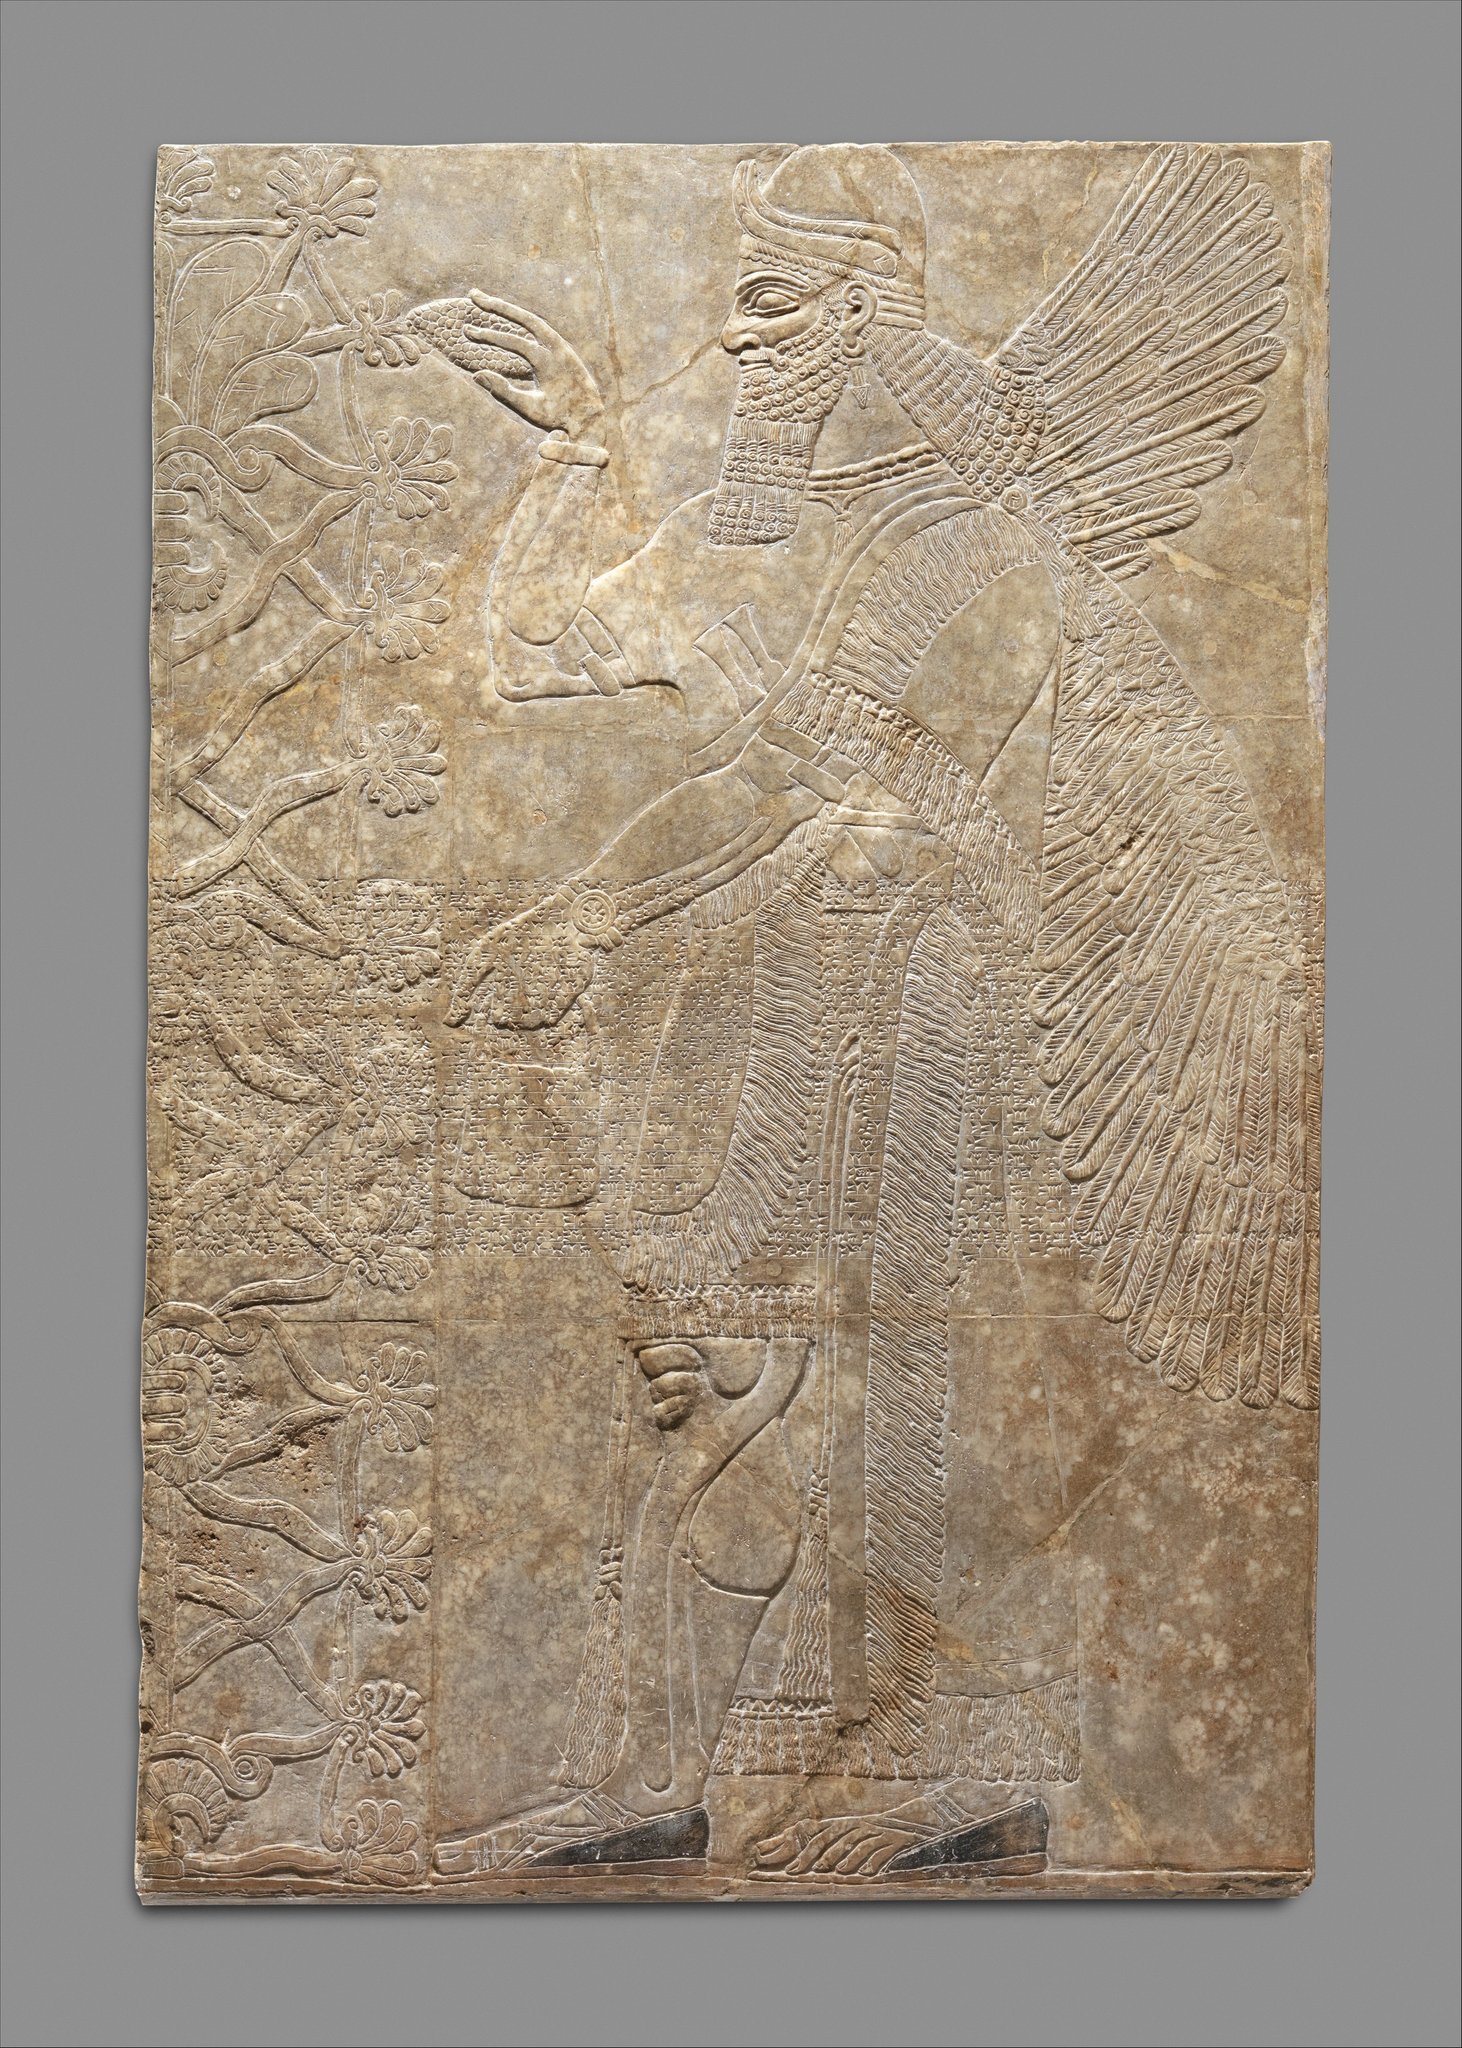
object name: relief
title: Relief panel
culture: assyrian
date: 883-859 BCE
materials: alabaster, gypsum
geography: mesopotamia